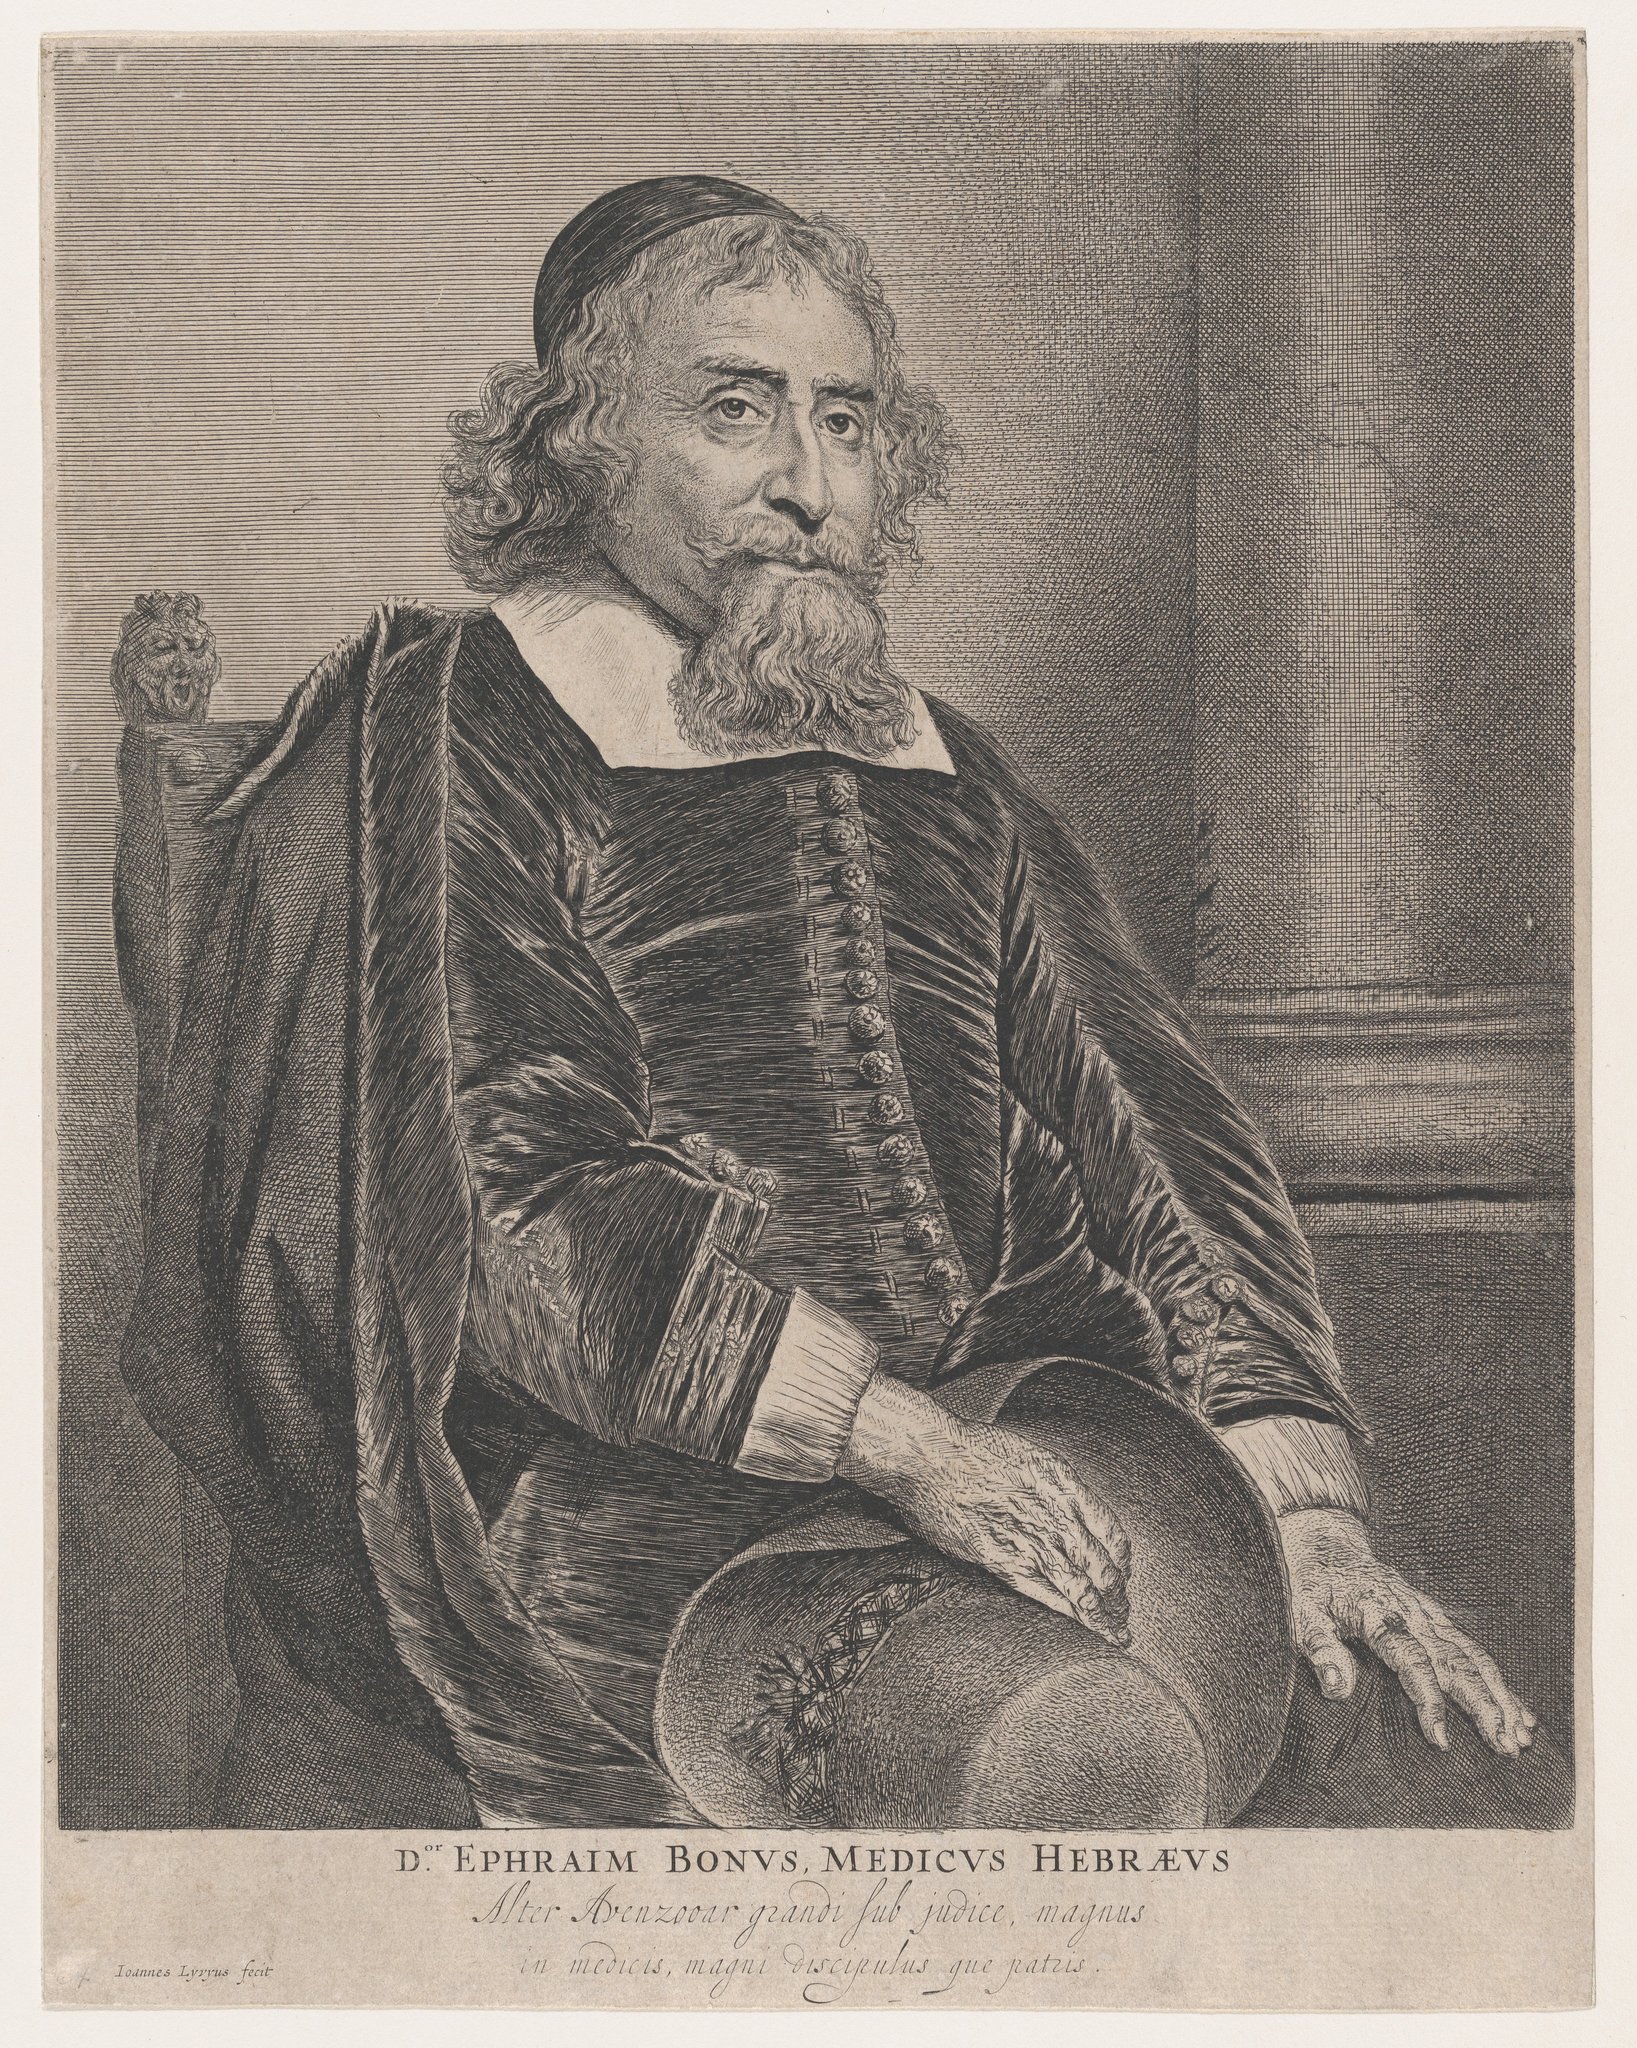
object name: print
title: Portrait of Ephraim Bonus, physician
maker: jan lievens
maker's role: artist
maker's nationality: dutch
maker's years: 1607-1674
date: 1601-1700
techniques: etching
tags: men,portraits,doctors